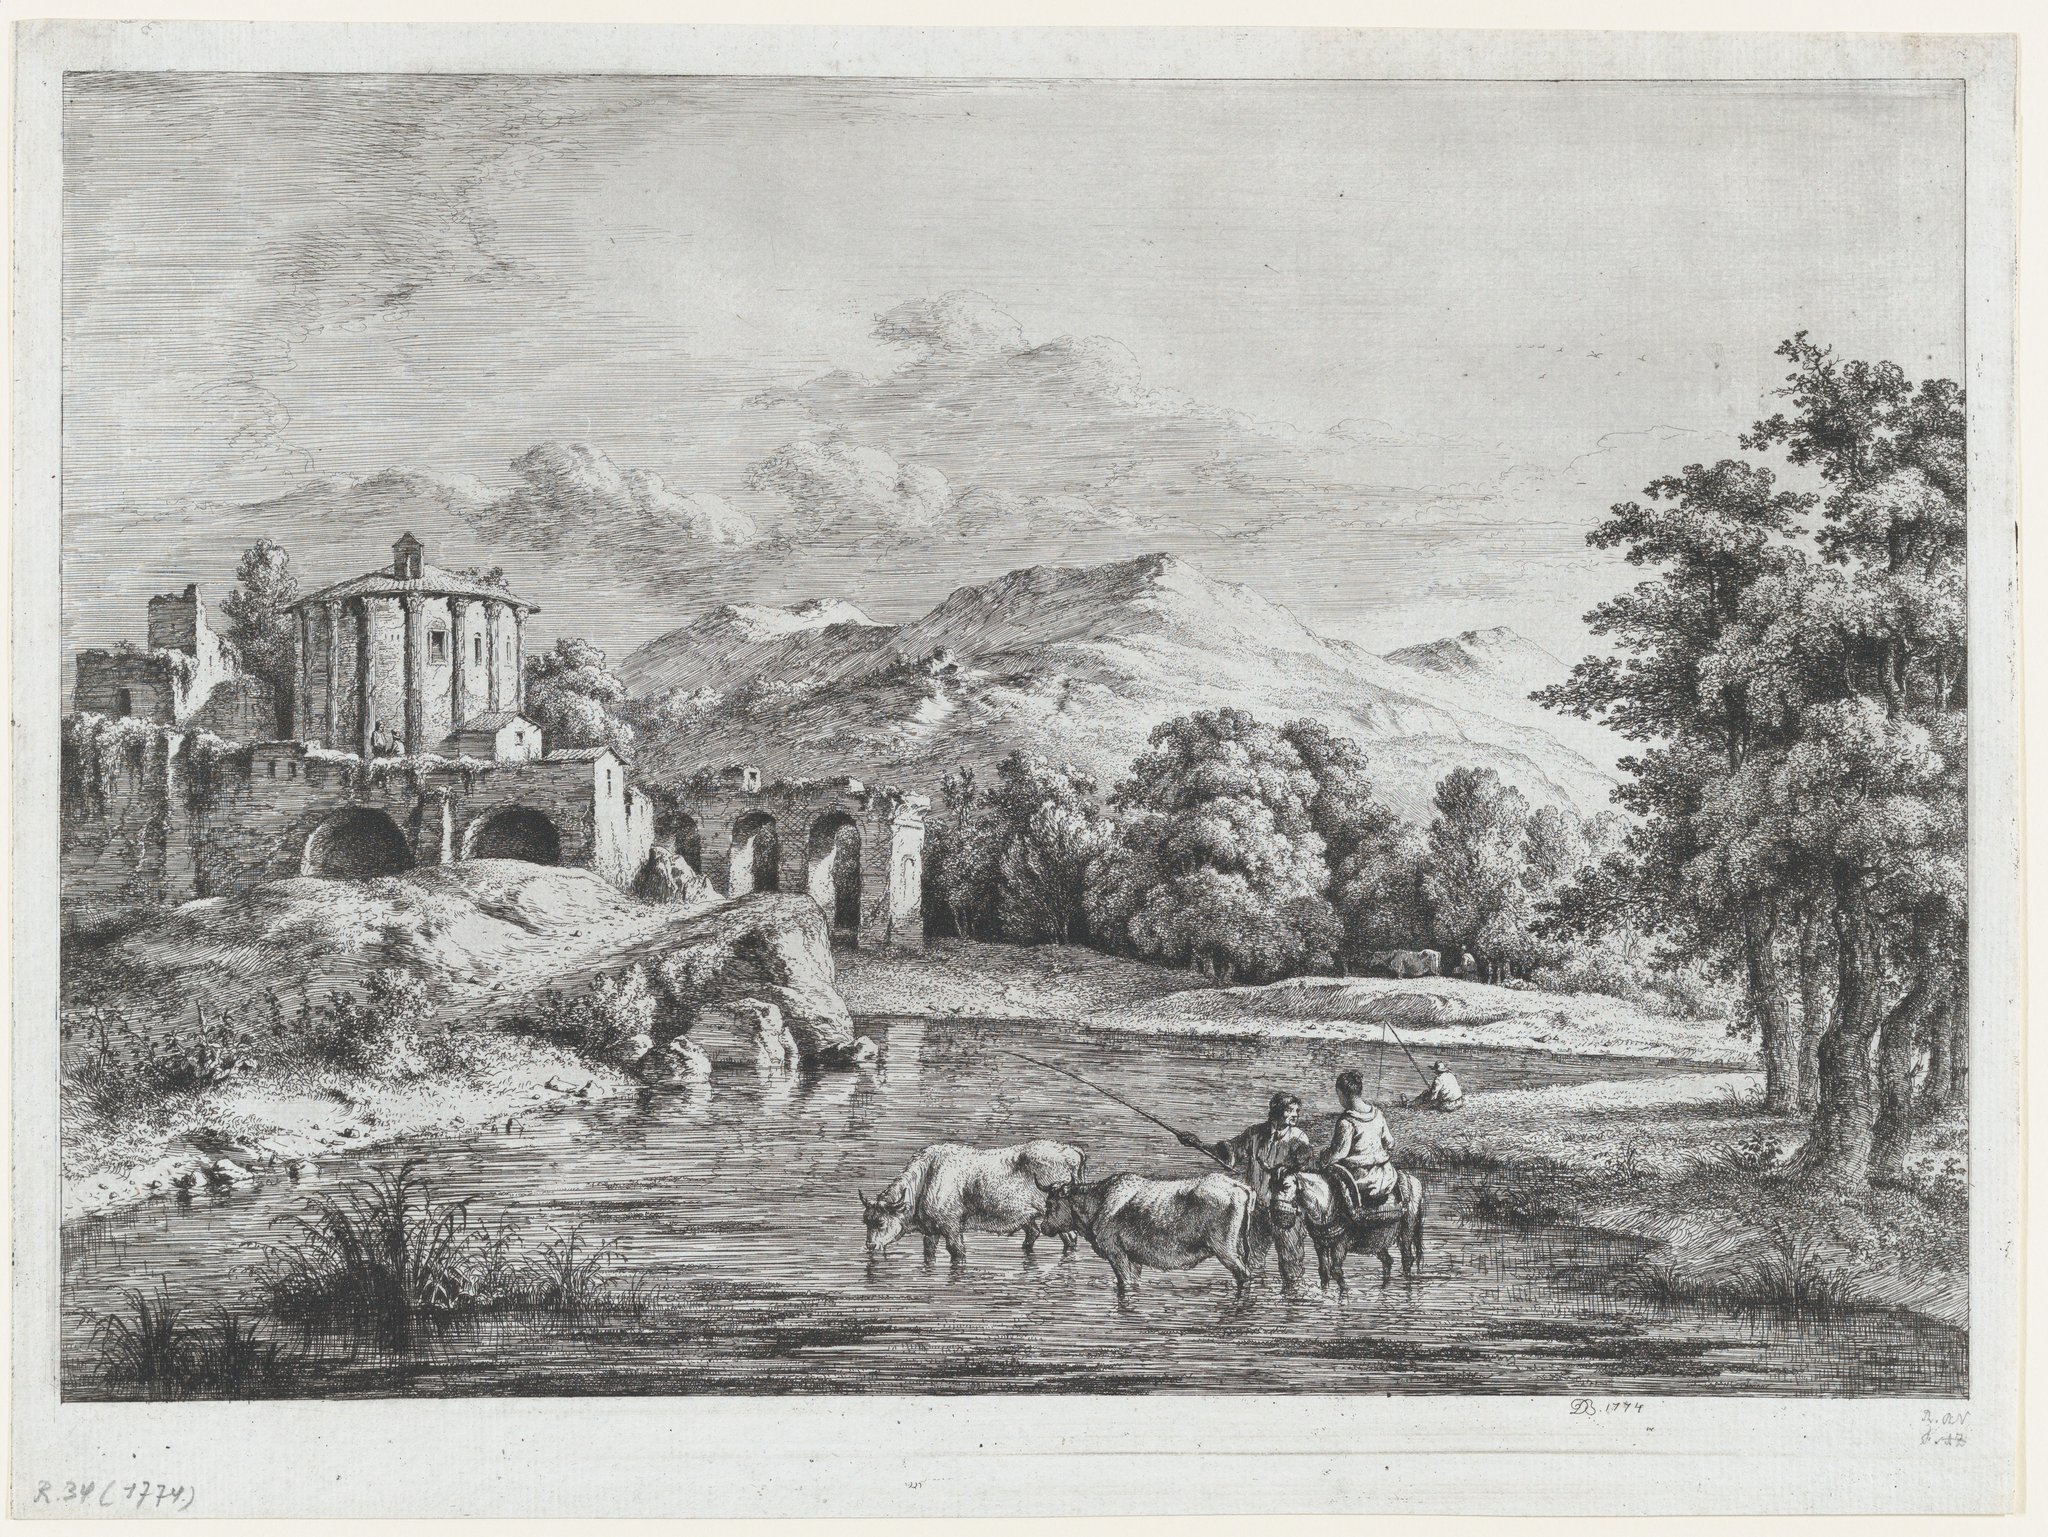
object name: print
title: View of the Temple of Vesta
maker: jean jacques de boissieu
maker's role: artist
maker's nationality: french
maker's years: 1736-1810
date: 1774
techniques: etching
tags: temples,cows,landscapes